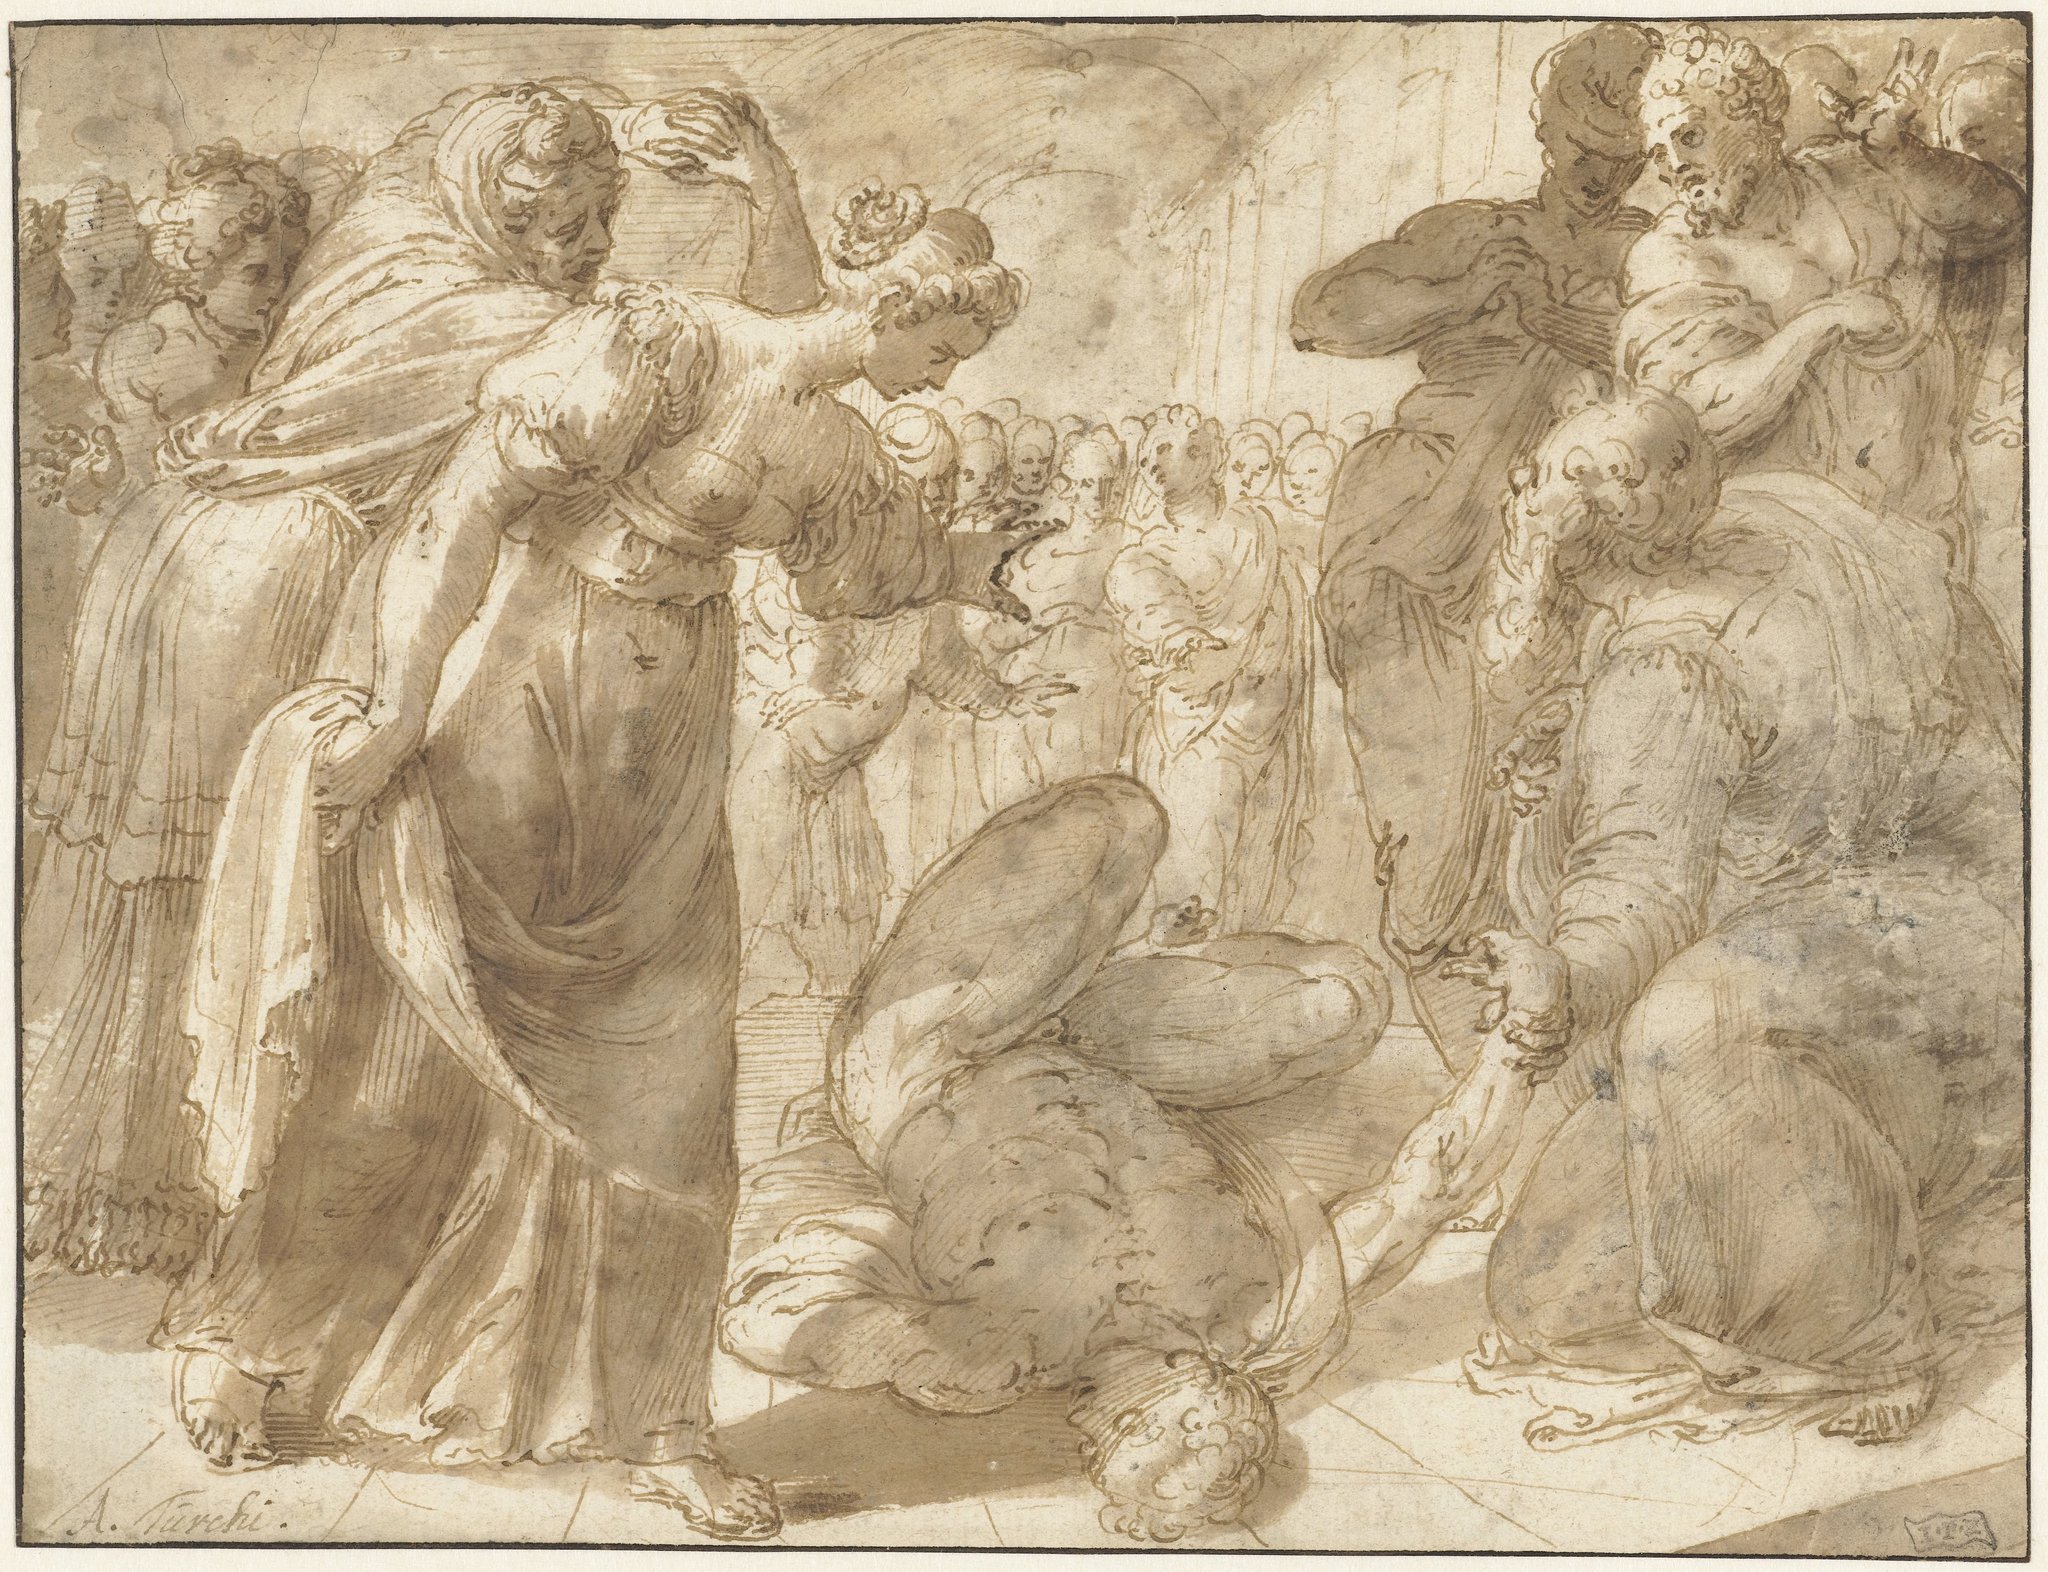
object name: drawing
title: De dood van Ananias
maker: alessandro turchi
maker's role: draughtsman, painter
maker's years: 1578-1649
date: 1588-1649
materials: ink, paper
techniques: brush, pen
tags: ananias, rebuked by peter, falls down and dies between his gifts